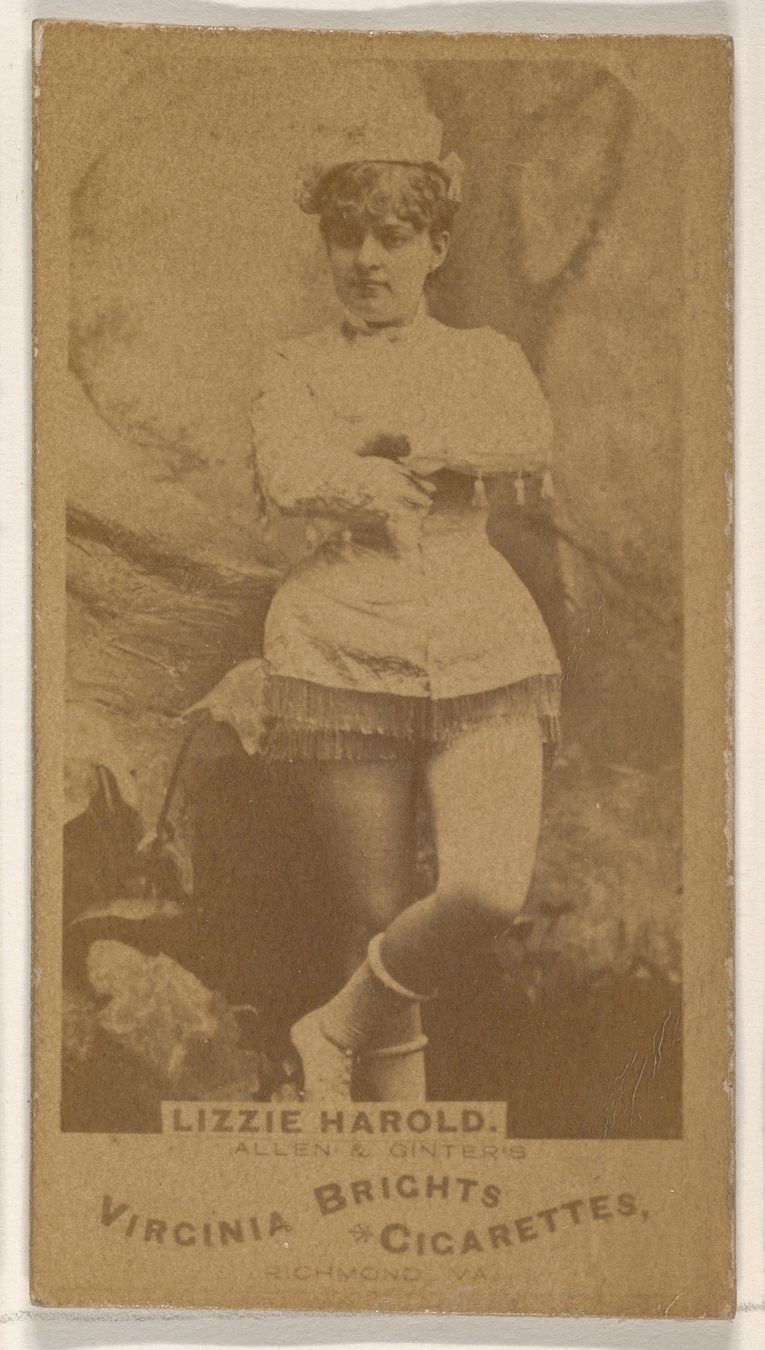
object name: photograph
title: Lizzie Harold, from the Actors and Actresses series (N45, Type 1) for Virginia Brights Cigarettes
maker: allen & ginter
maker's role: publisher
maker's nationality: american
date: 1888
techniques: albumen silver print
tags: portraits,women,actresses